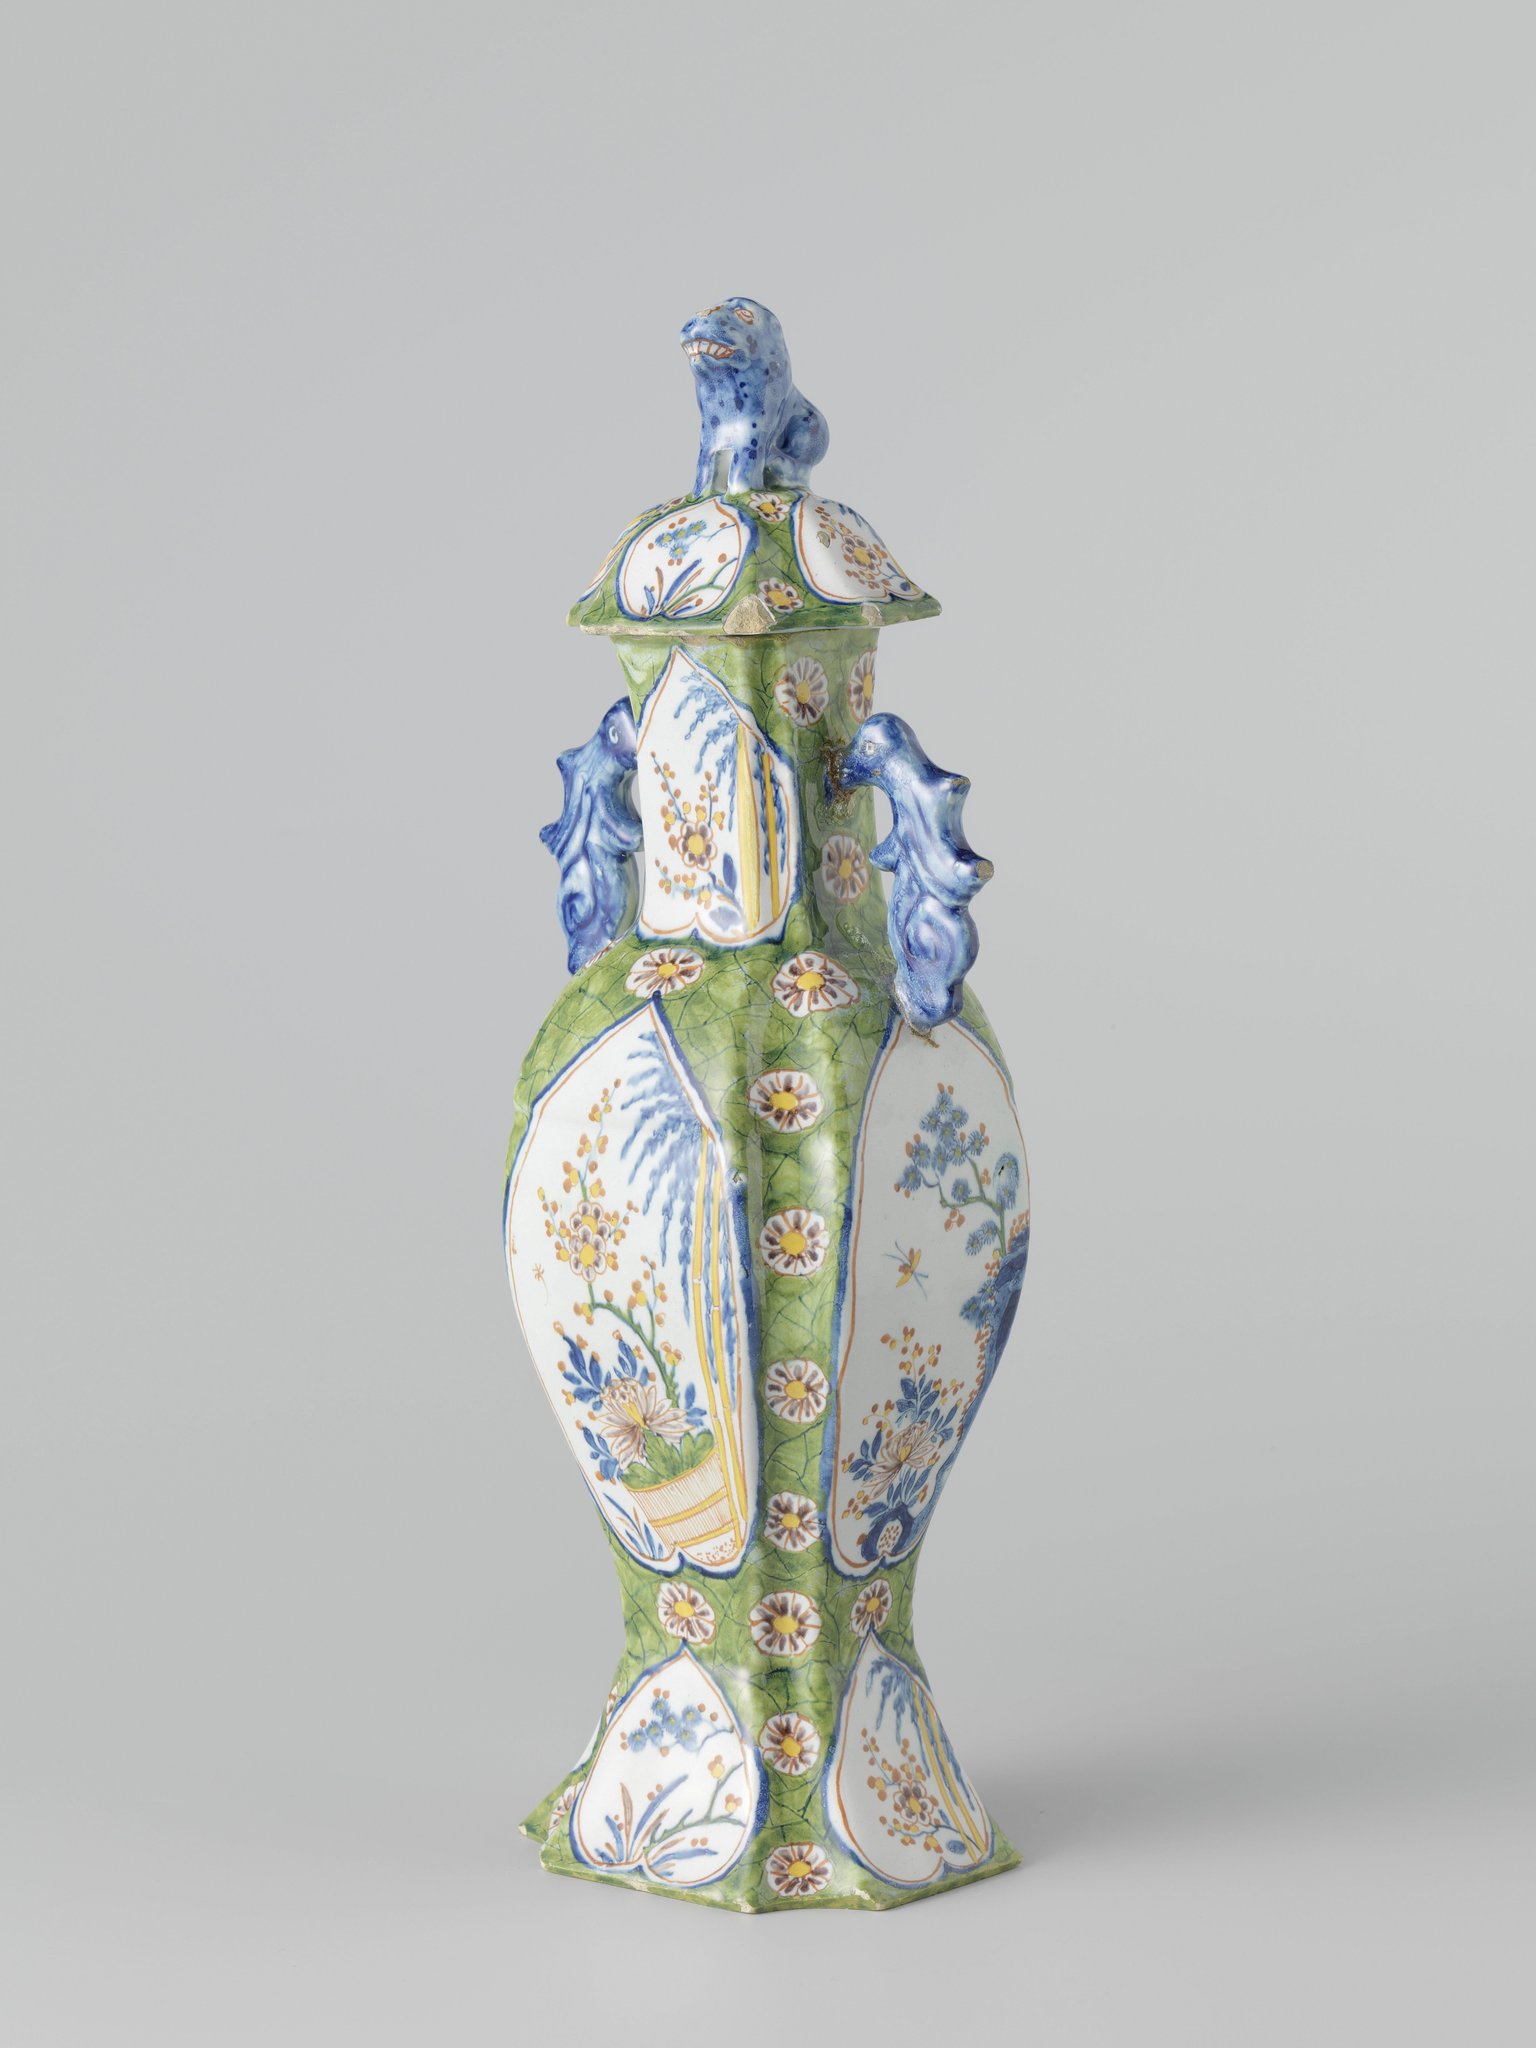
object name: kaststel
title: Dekselpot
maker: Anonymous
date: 1740-1780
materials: faience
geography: delft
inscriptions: mark: ‘D / 7’, collector's mark: ‘koninklijk oudheidkundig genootschap nr. 29’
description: Dekselpot van faience. Veelkleurig beschilderd. De dekselpot is onderdeel van een kaststel.